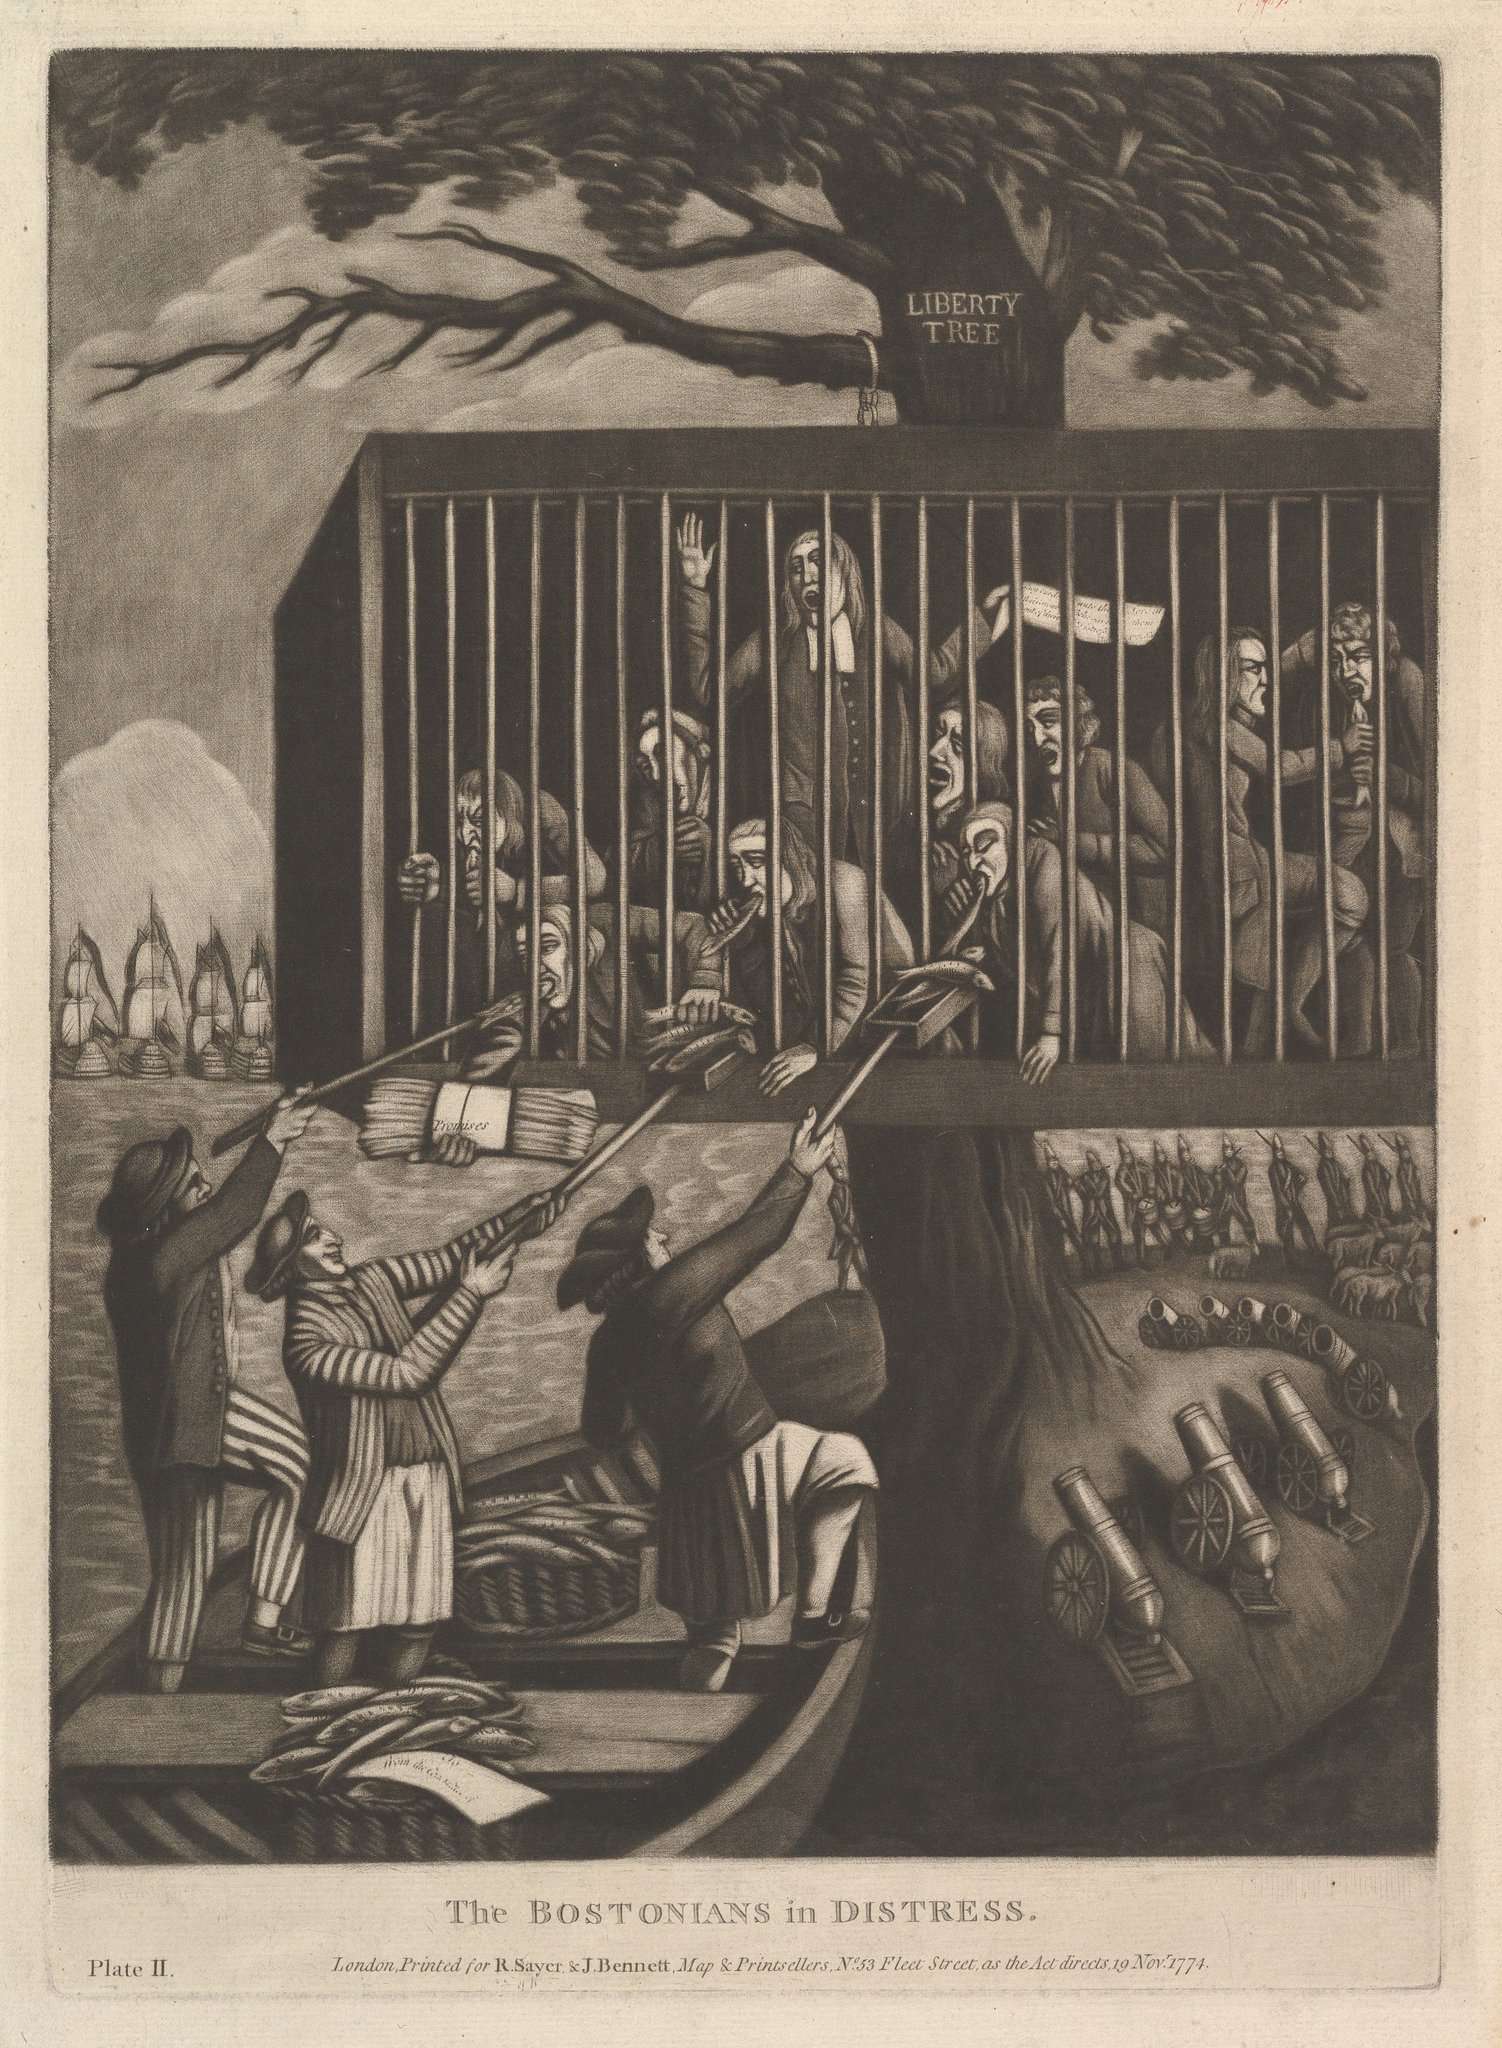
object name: print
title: The Bostonians in Distress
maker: philip dawe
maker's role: artist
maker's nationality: british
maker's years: 1745-1809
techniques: mezzotint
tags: satire,american revolution,men,politics